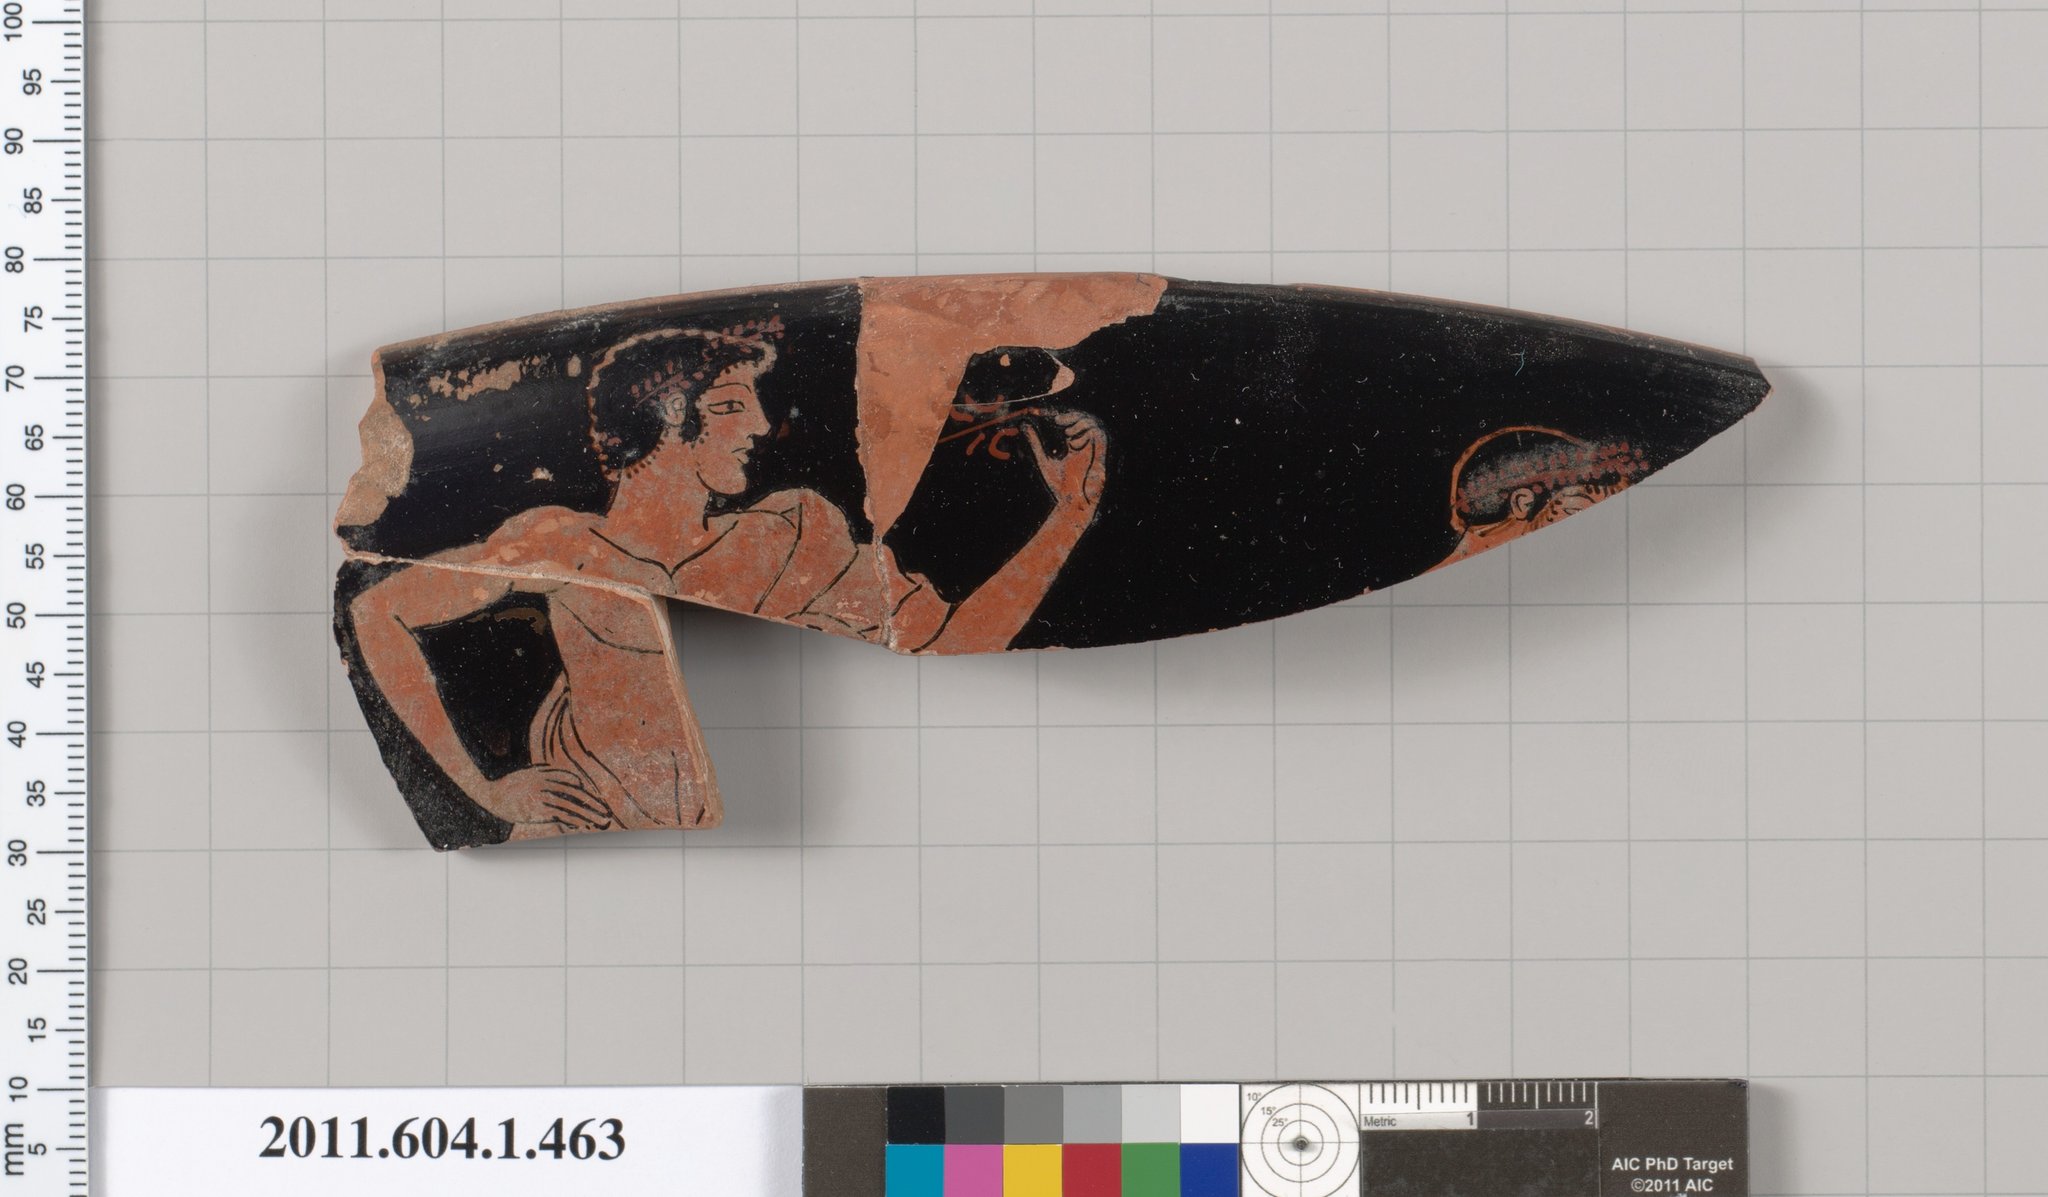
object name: kylix fragment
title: Terracotta rim fragment of a kylix (drinking cup)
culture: greek, attic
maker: makron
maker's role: artist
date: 490-480 BCE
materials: terracotta